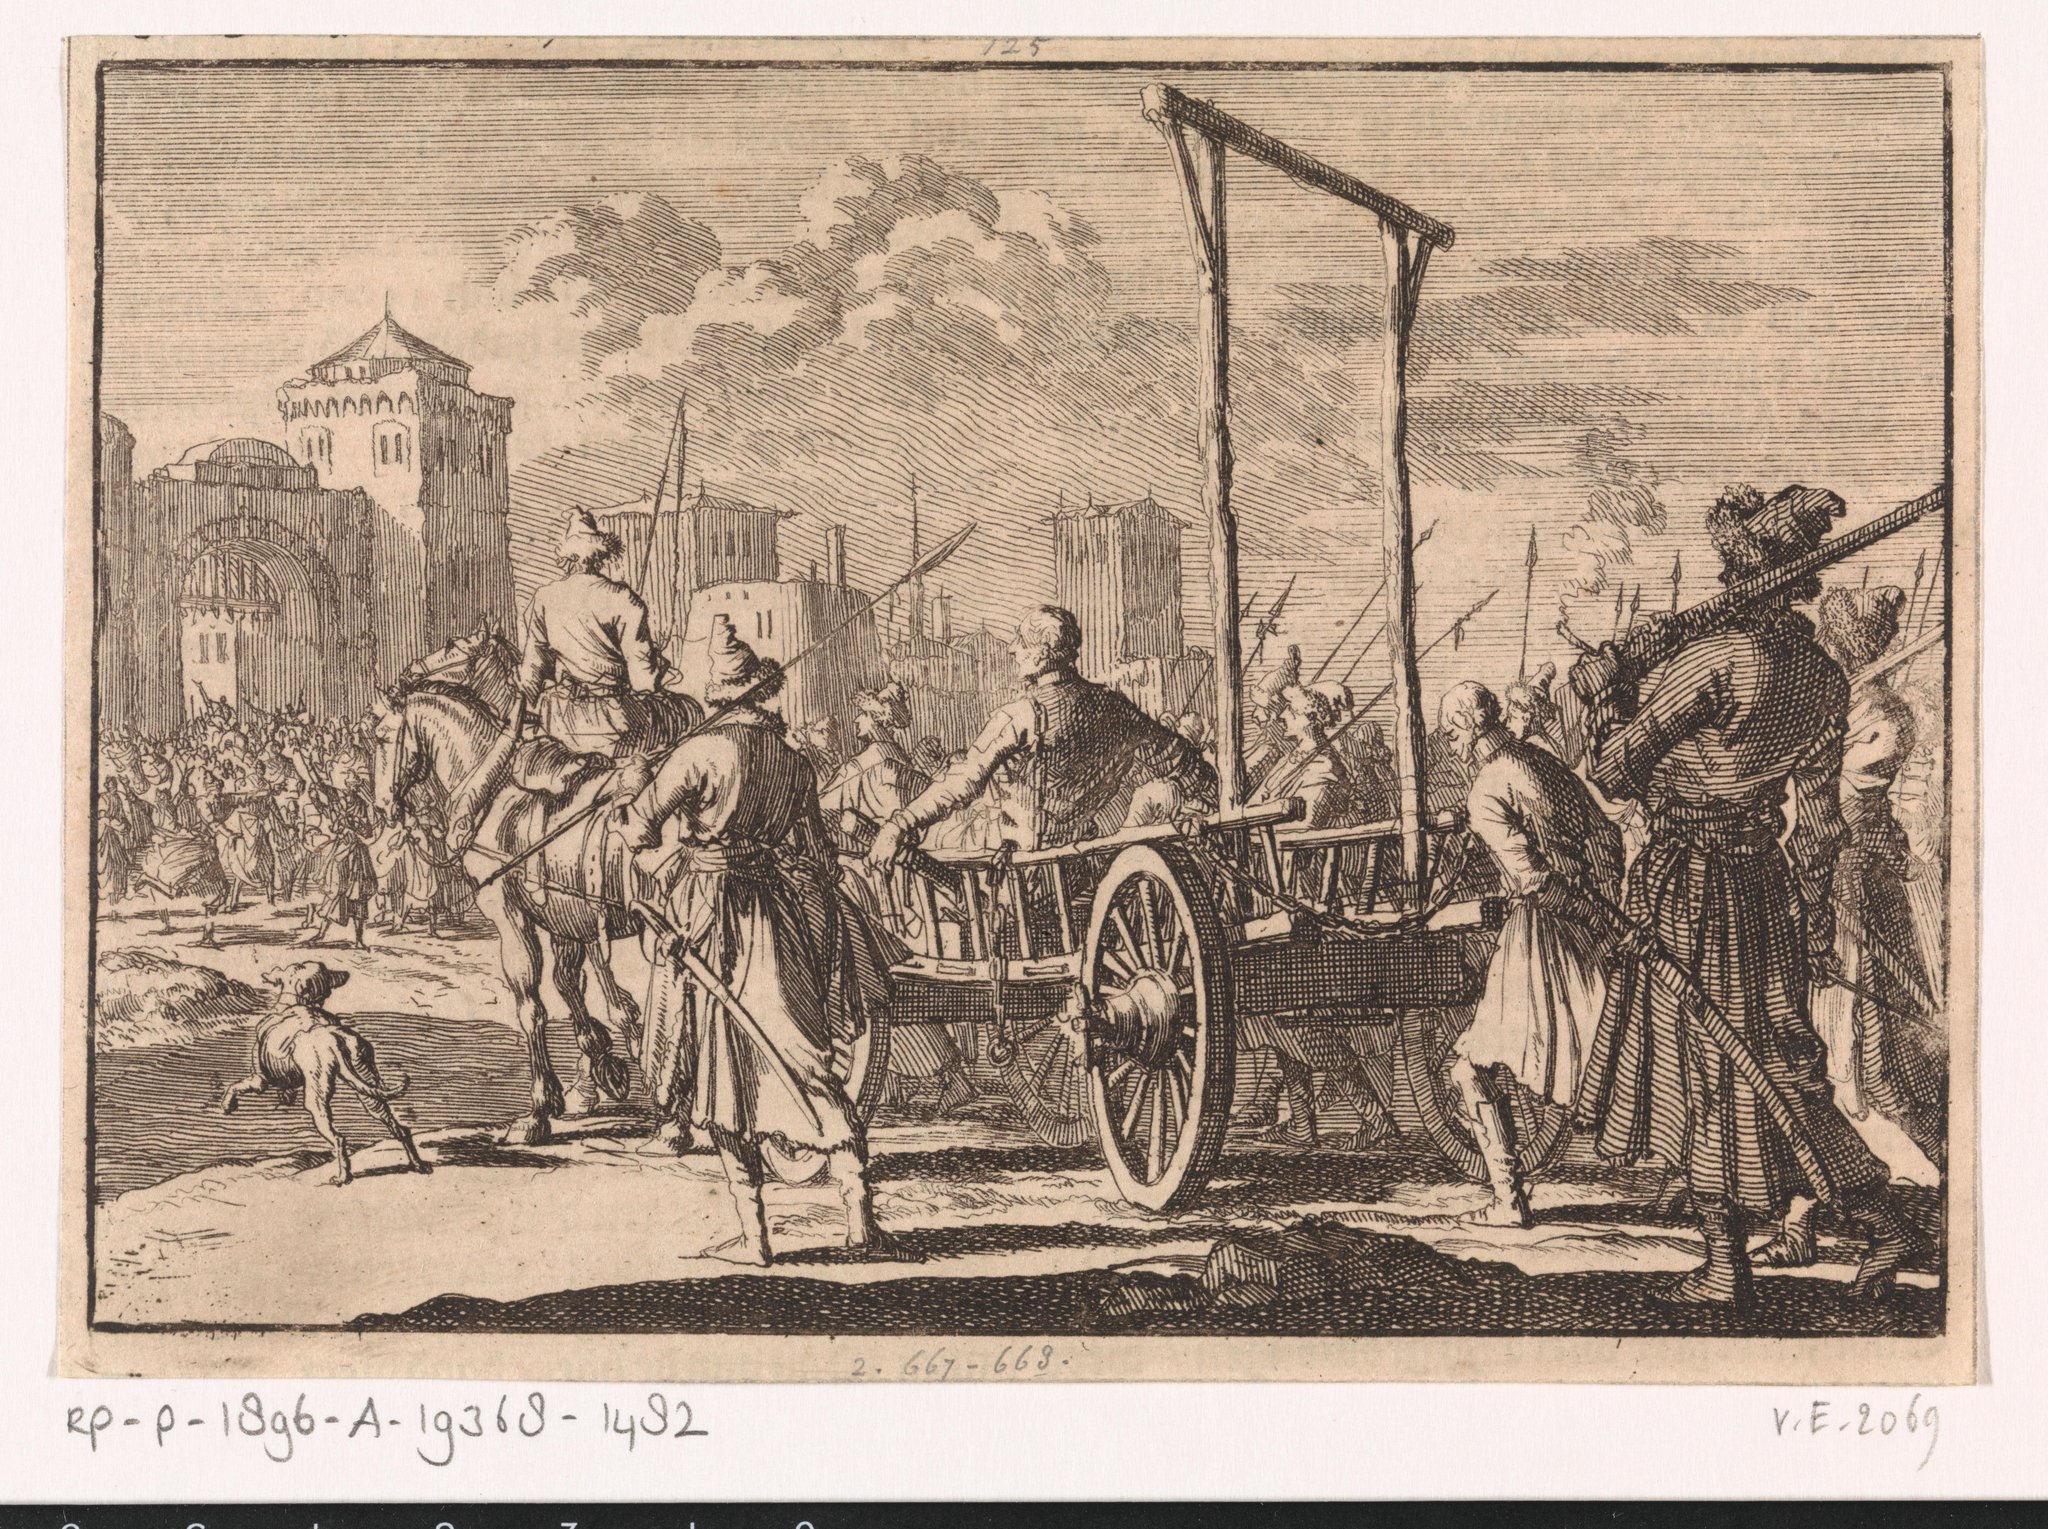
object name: book illustration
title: Stenko Radzin wordt met zijn broer Froika op een kar Moskou binnengebracht, 1671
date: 1700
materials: paper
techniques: etching, letterpress printing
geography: amsterdam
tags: transport (of arrested person)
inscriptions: collector's mark: Lugt 2228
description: Illustratie uit: Gottfried, Johann Ludwig. Historische kronyck: Omstandigh vervolgh op Joh. Lodew. Gottfrieds Historische kronyck, of algemeene historische gedenk-boeken der voornaemste uytgeleesenste weereldlycke en kercklycke geschiedenissen, Leiden: Pieter van der Aa, 1700, dl. 2, p. 667.